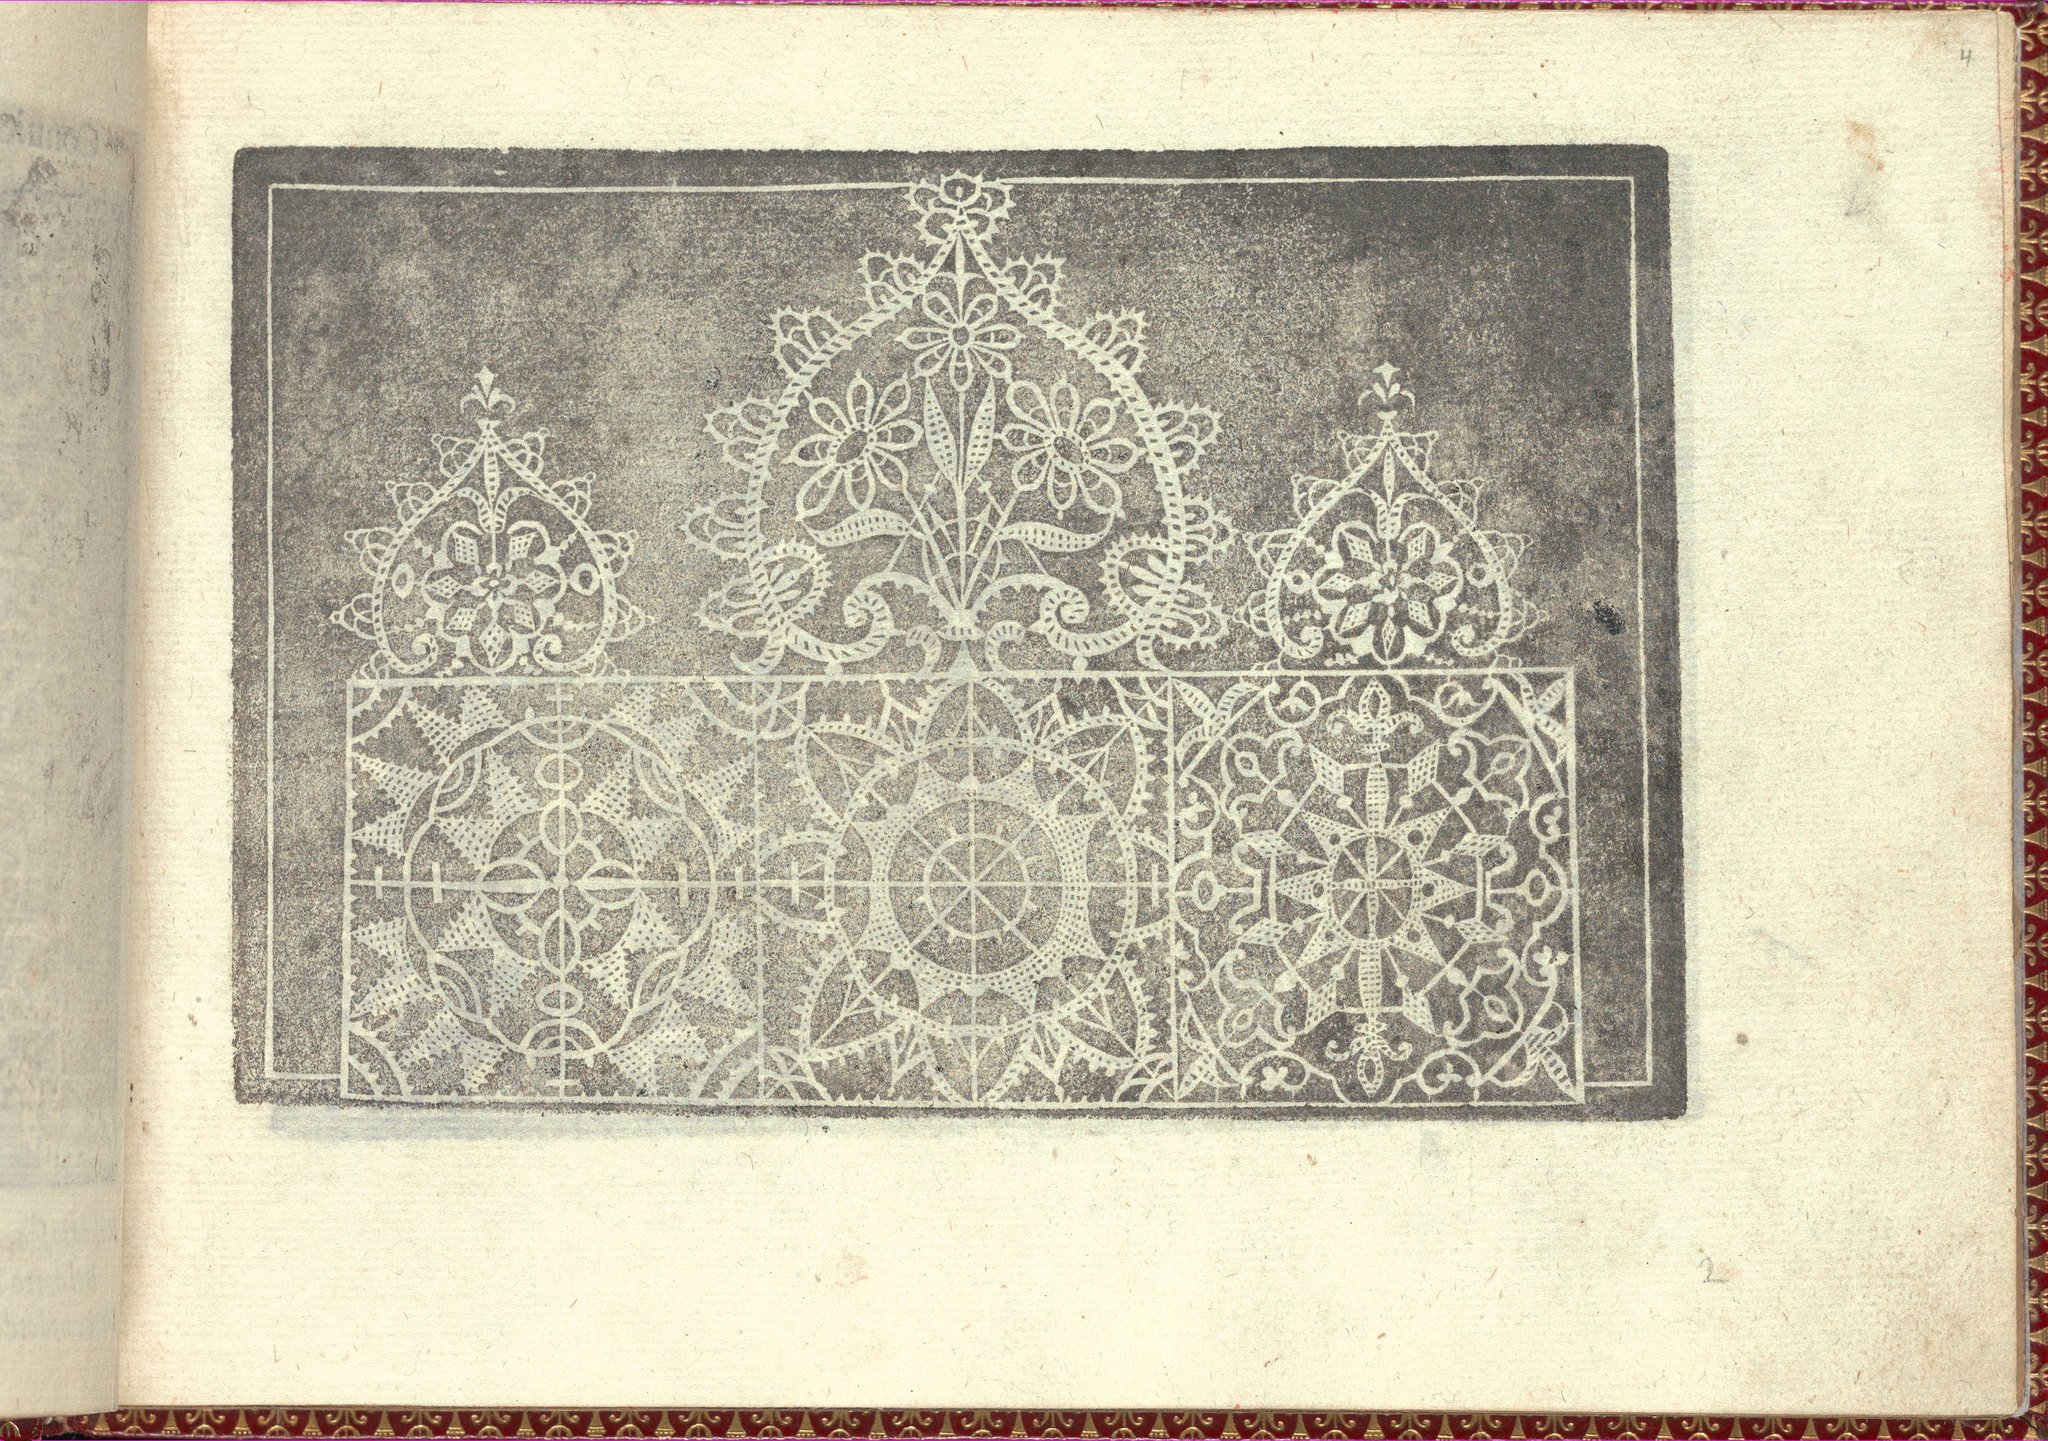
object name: book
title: Corona delle Nobili et Virtuose Donne: Libro I-IV, page 4 (recto)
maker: cesare vecellio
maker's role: publisher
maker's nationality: italian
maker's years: 1521-1601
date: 1601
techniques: woodcut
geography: italy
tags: ornament